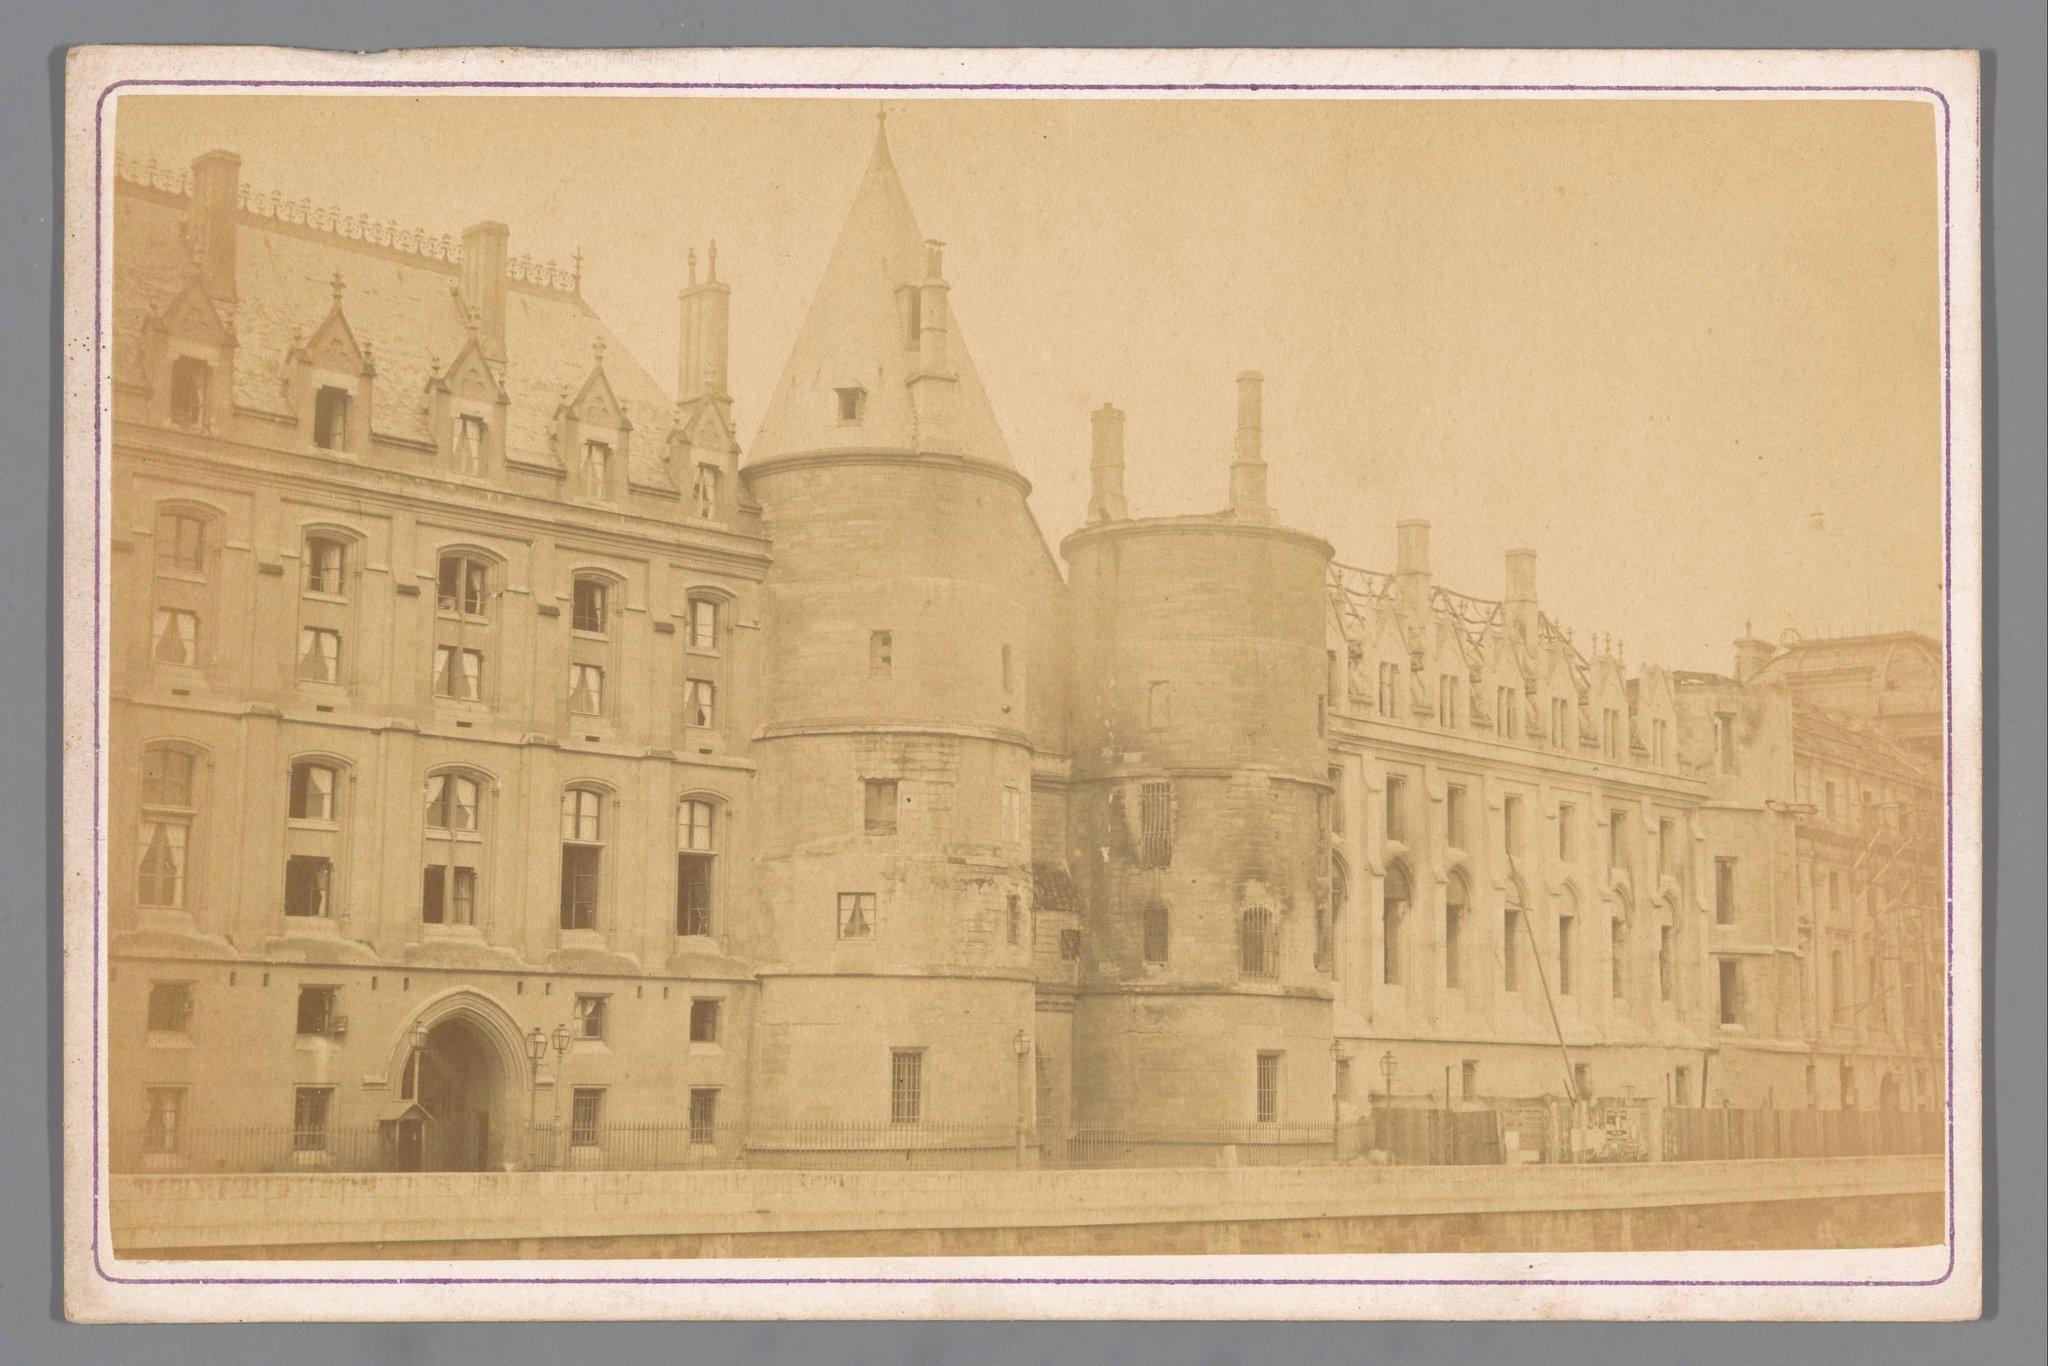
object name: cabinet photograph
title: Gezicht op het Paleis van Justitie in Parijs na de brand door de Commune van Parijs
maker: Anonymous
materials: cardboard, photographic support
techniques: albumen print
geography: paris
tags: court building, ruin of a building ~ architecture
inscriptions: annotation: ‘Palais de Justice/ Lo[cation] de la cour de Cassation’